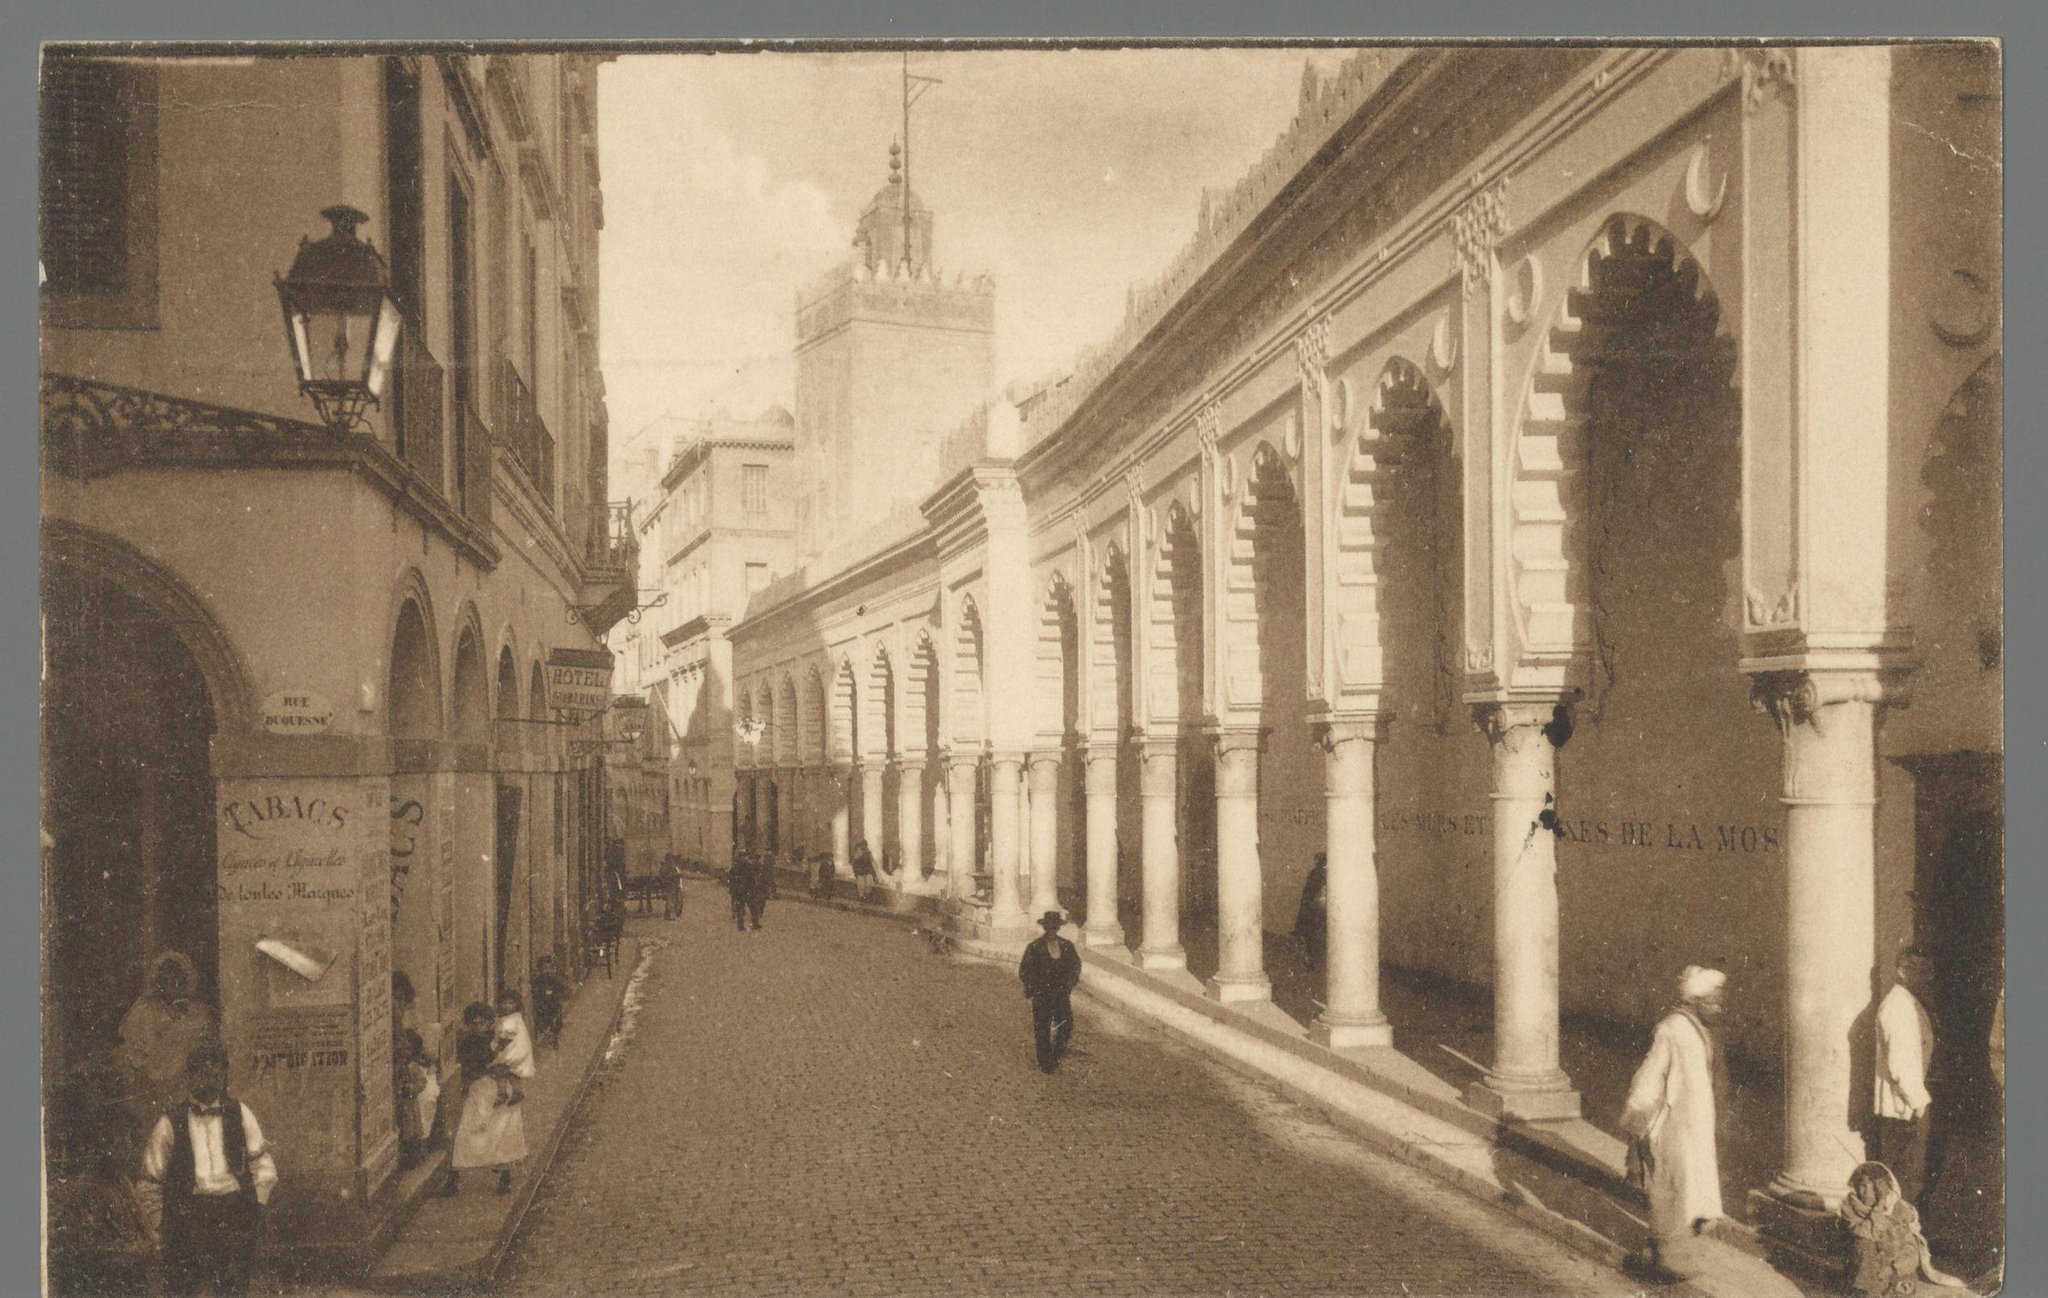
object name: photomechanical print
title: Alger. Mosquée Djemaa-el-Kebir. Rue de la Marine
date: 1903-1905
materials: cardboard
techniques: photograph, writing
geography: paris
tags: temple, shrine ~ islam, mohammedanism, street (+ city(-scape) with figures, staffage)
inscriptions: postage stamp